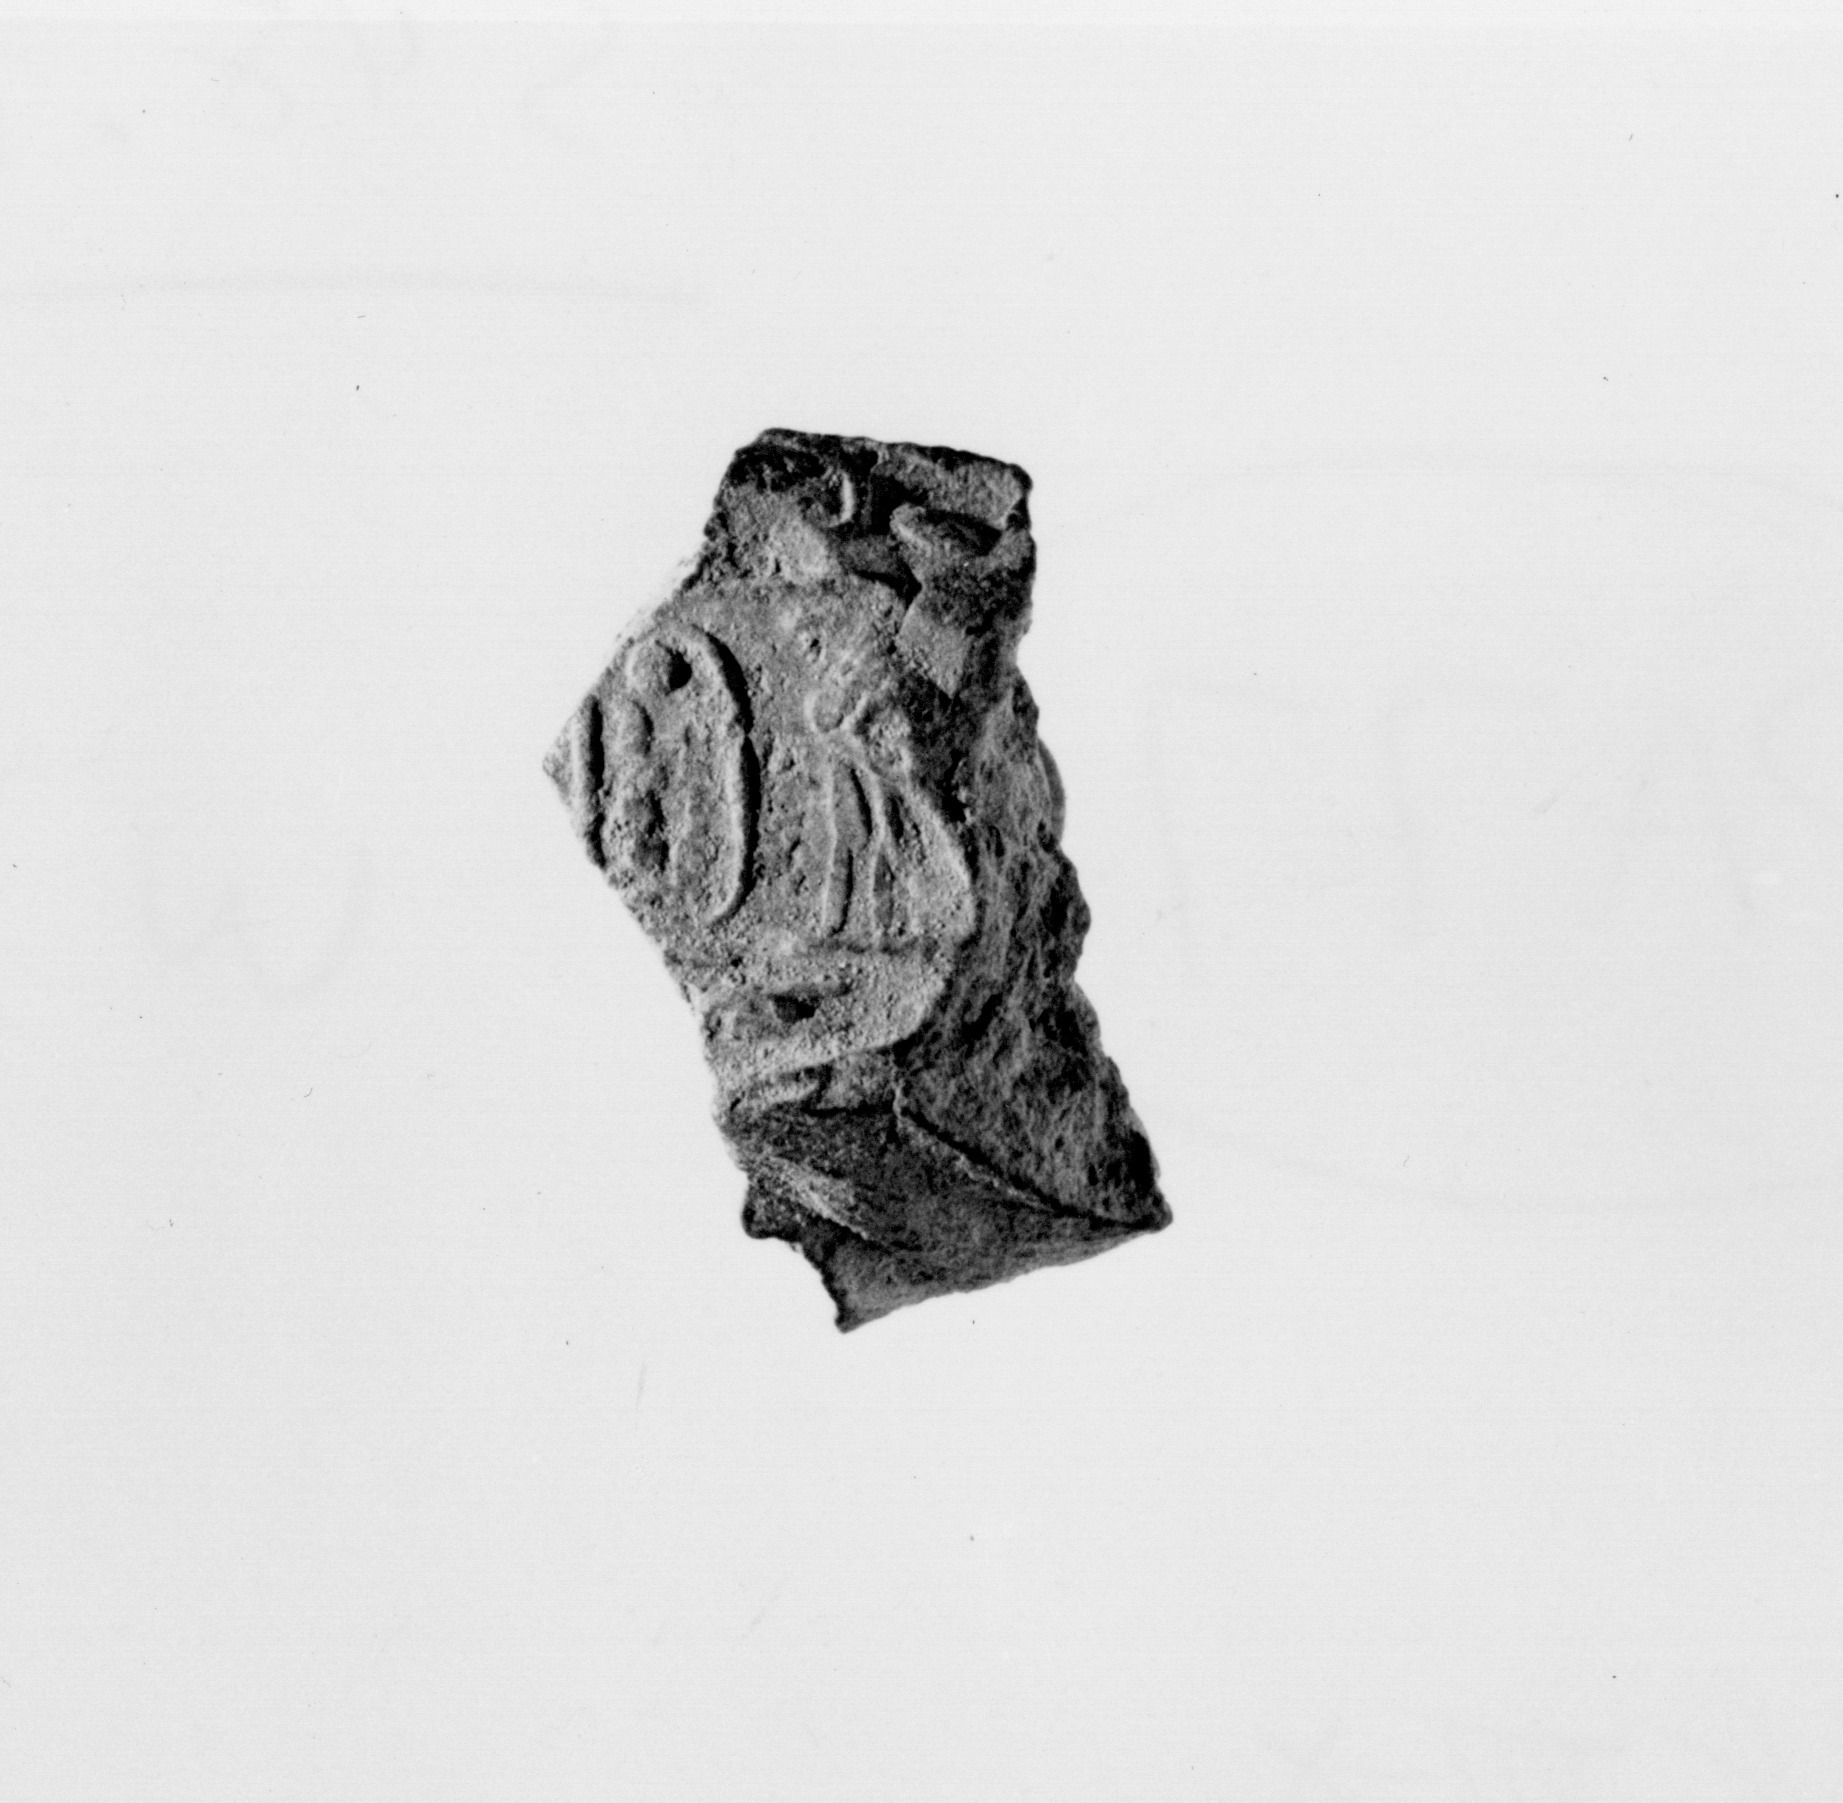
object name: sealing, nebmaatre, amenhotep iii, horus, falcon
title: Document Sealing With the Throne Name of Amenhotep III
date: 1390-1352 BCE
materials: mud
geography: egypt